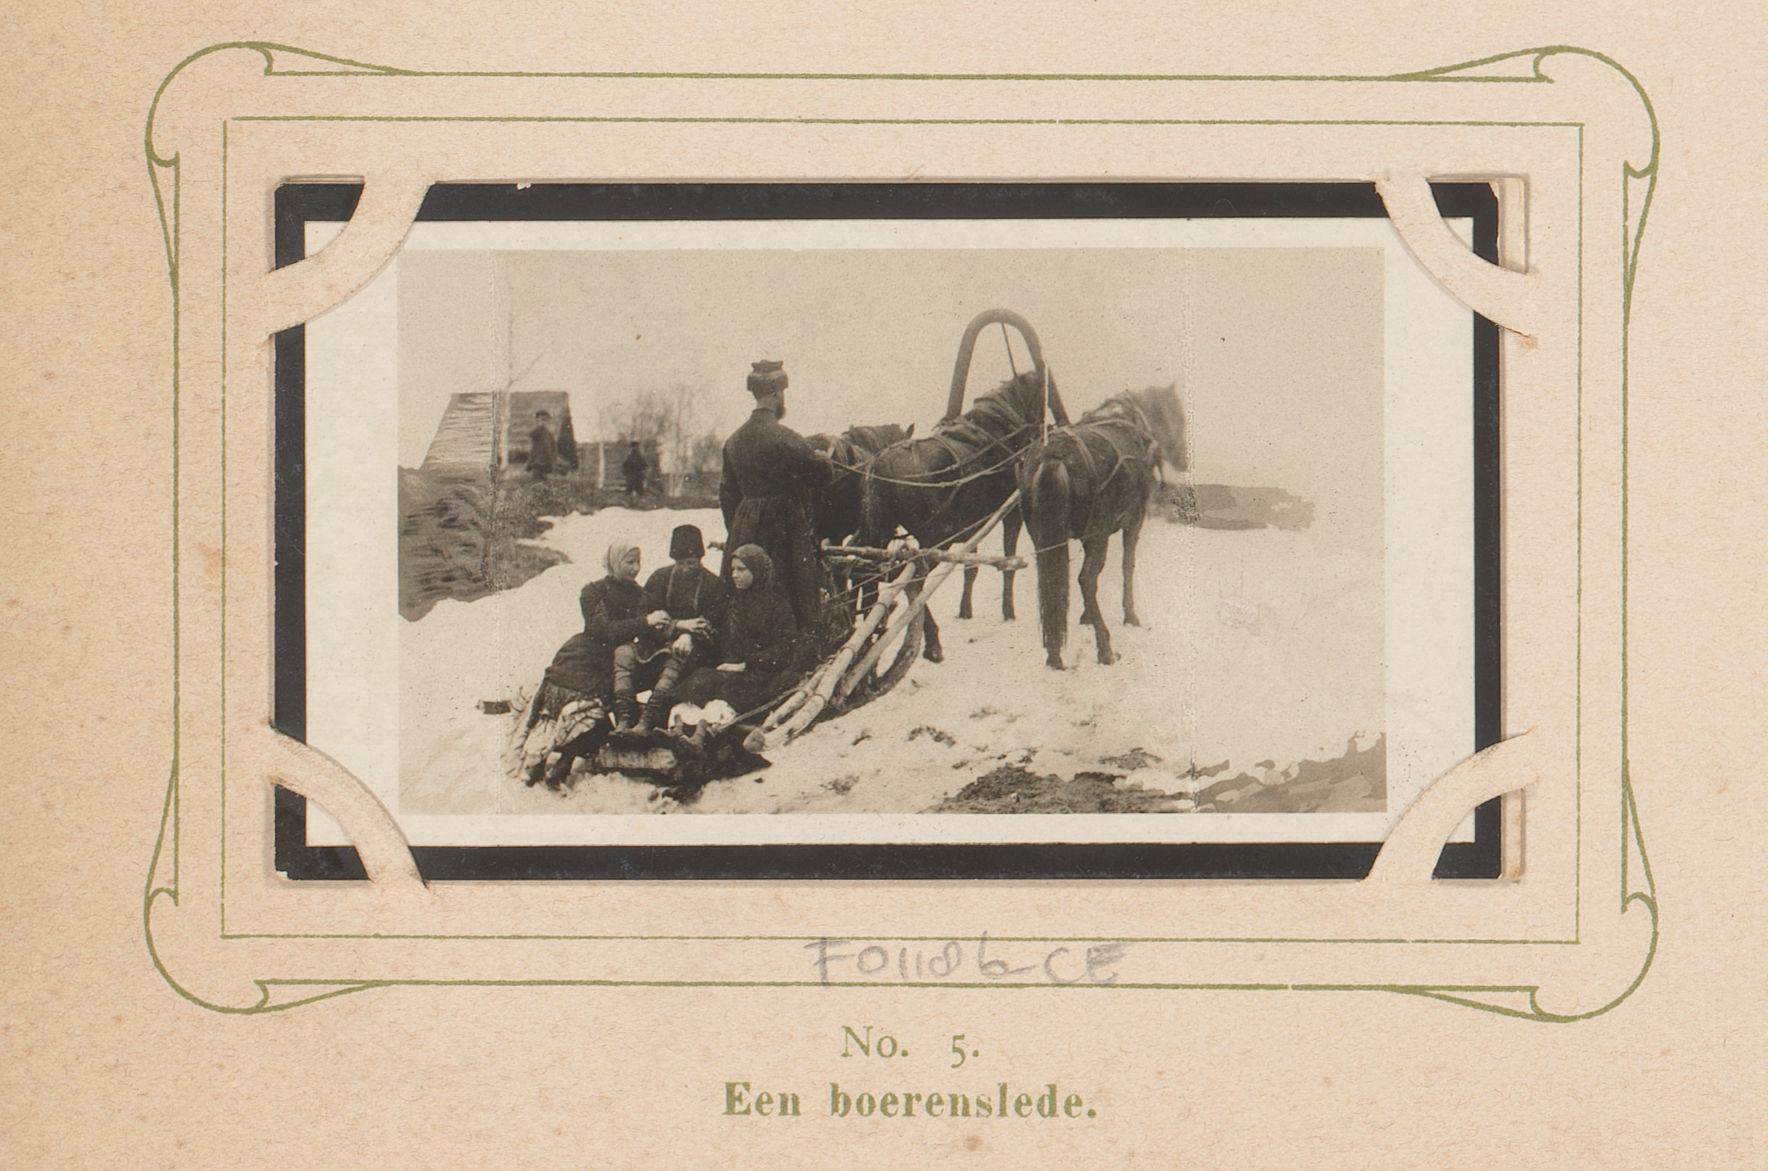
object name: photograph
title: Troika met boerenfamilie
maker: Anonymous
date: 1904-1905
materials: photographic support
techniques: gelatin silver print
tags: farmers, (farm) wagon, freight wagon, cart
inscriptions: inscription: ‘No. 5./ Een boerenslede.’